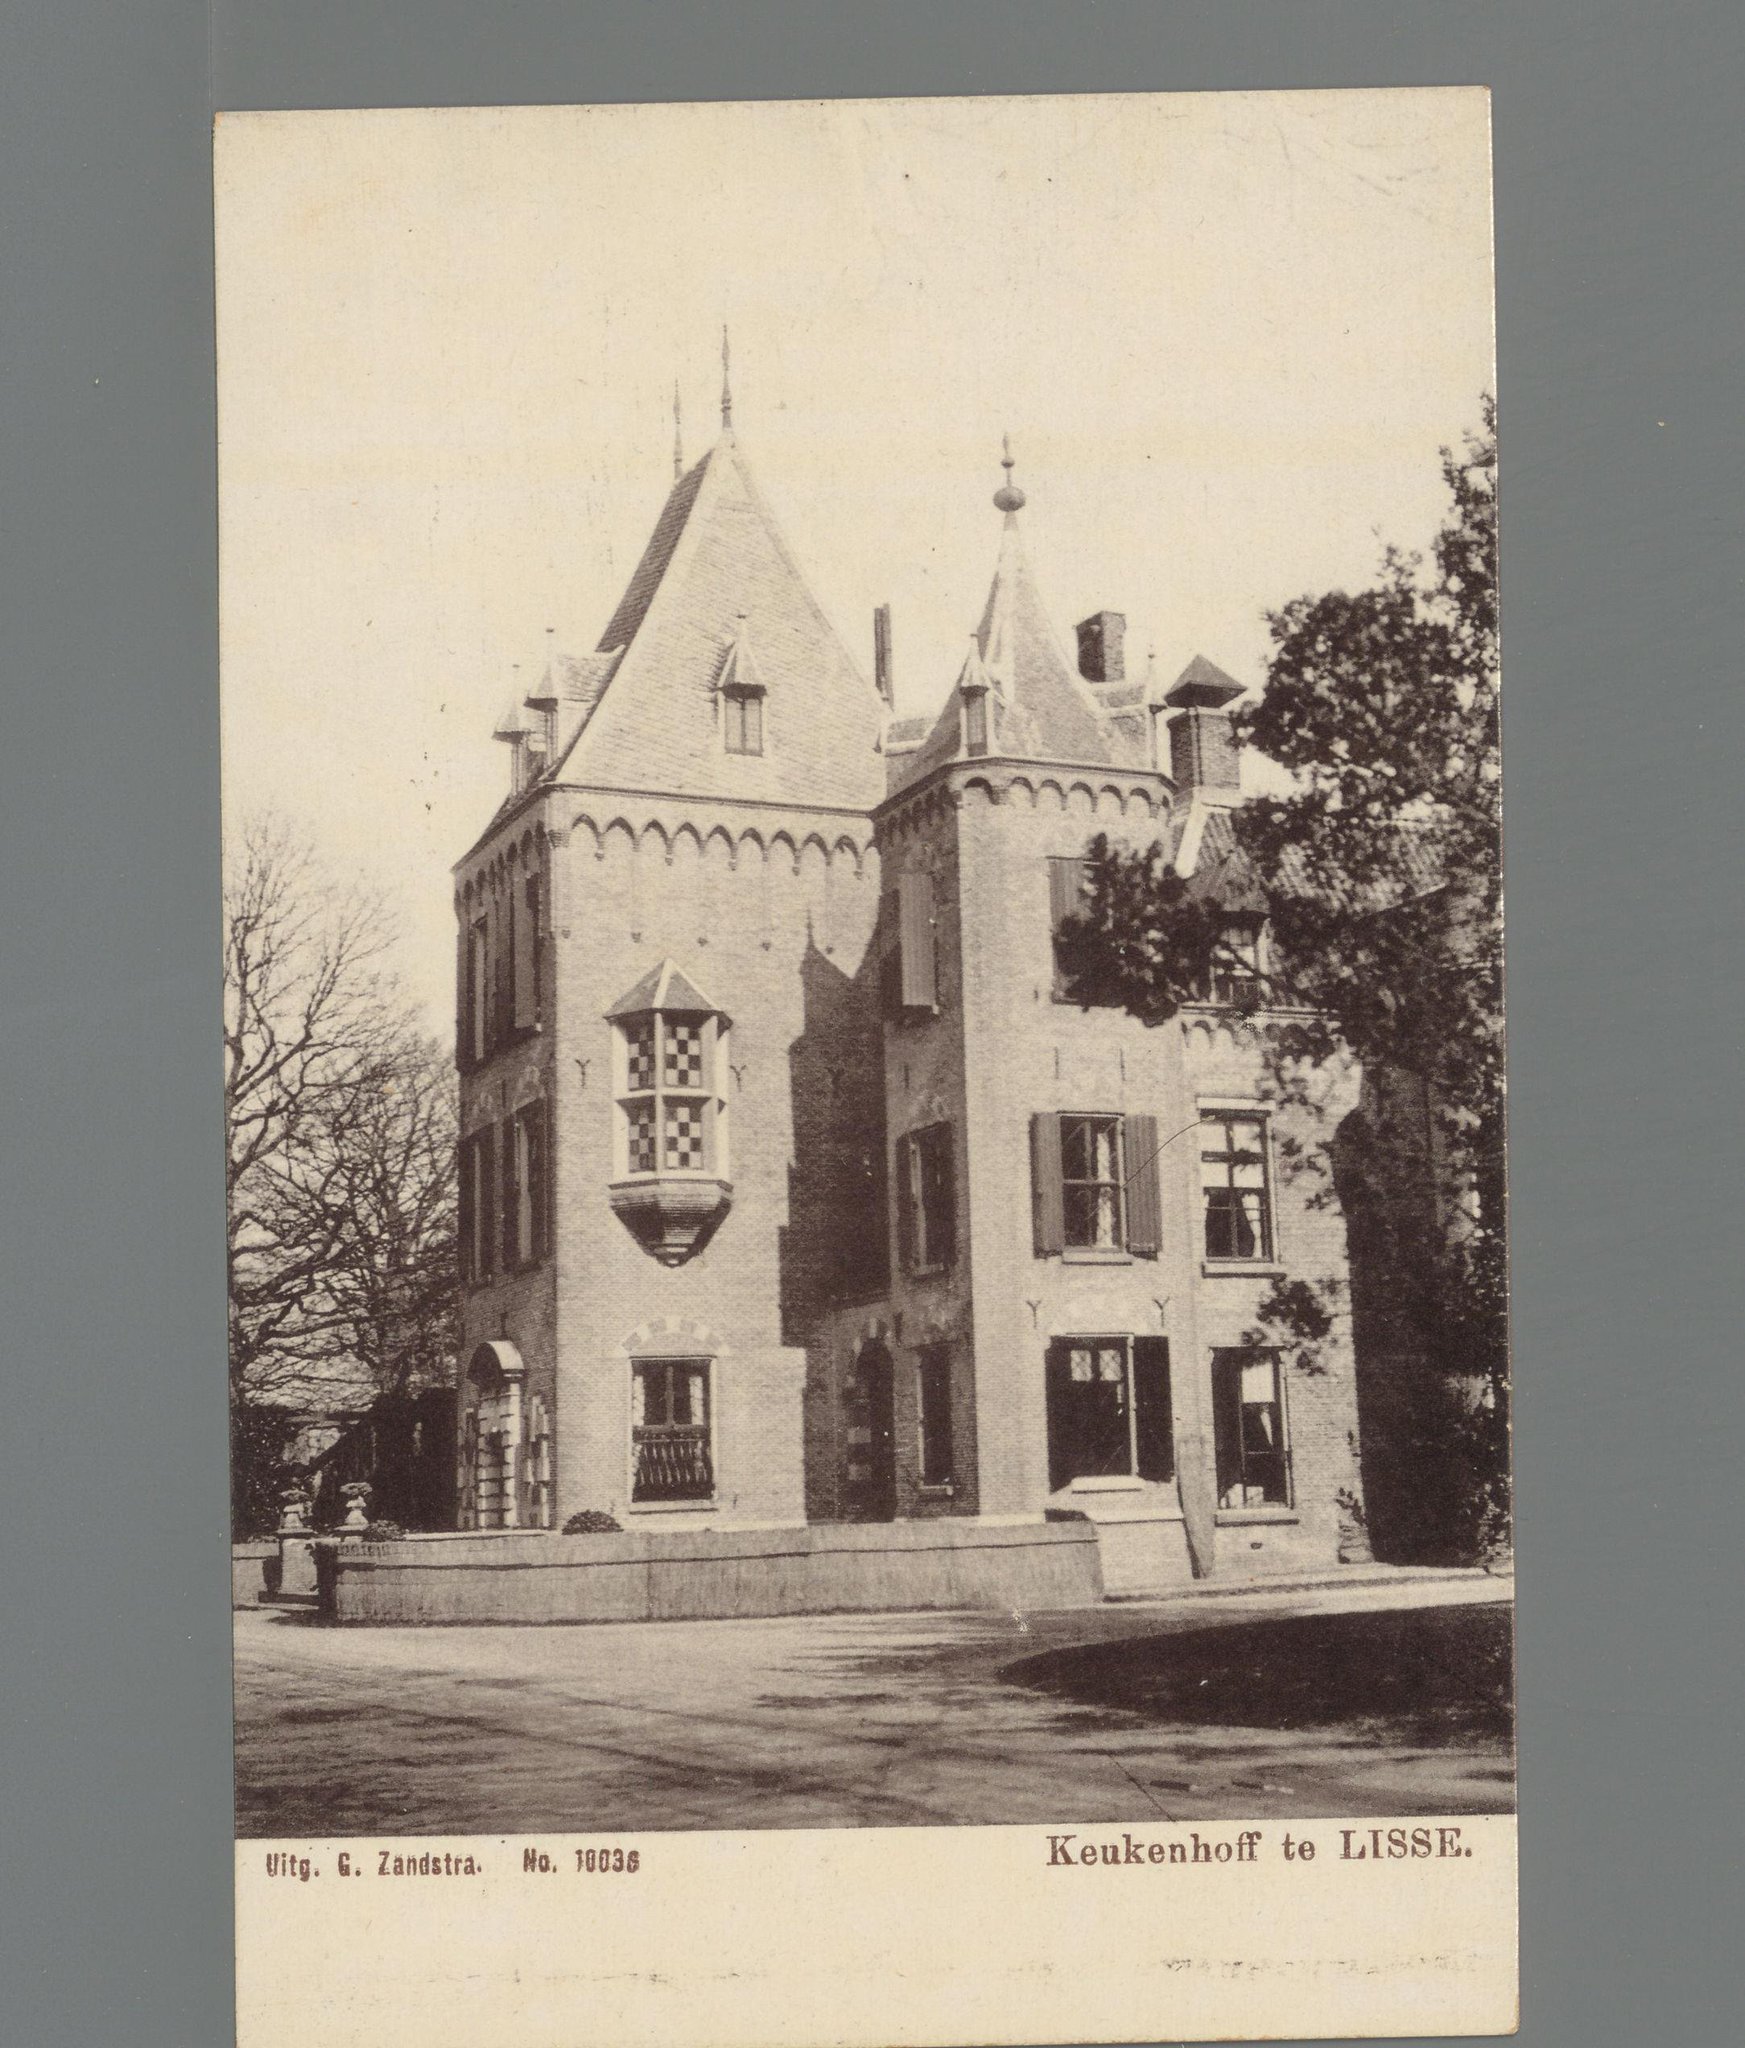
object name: ansichtkaart, prentbriefkaart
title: Keukenhoff te Lisse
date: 1897-1905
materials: cardboard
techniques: photograph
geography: lisse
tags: castle